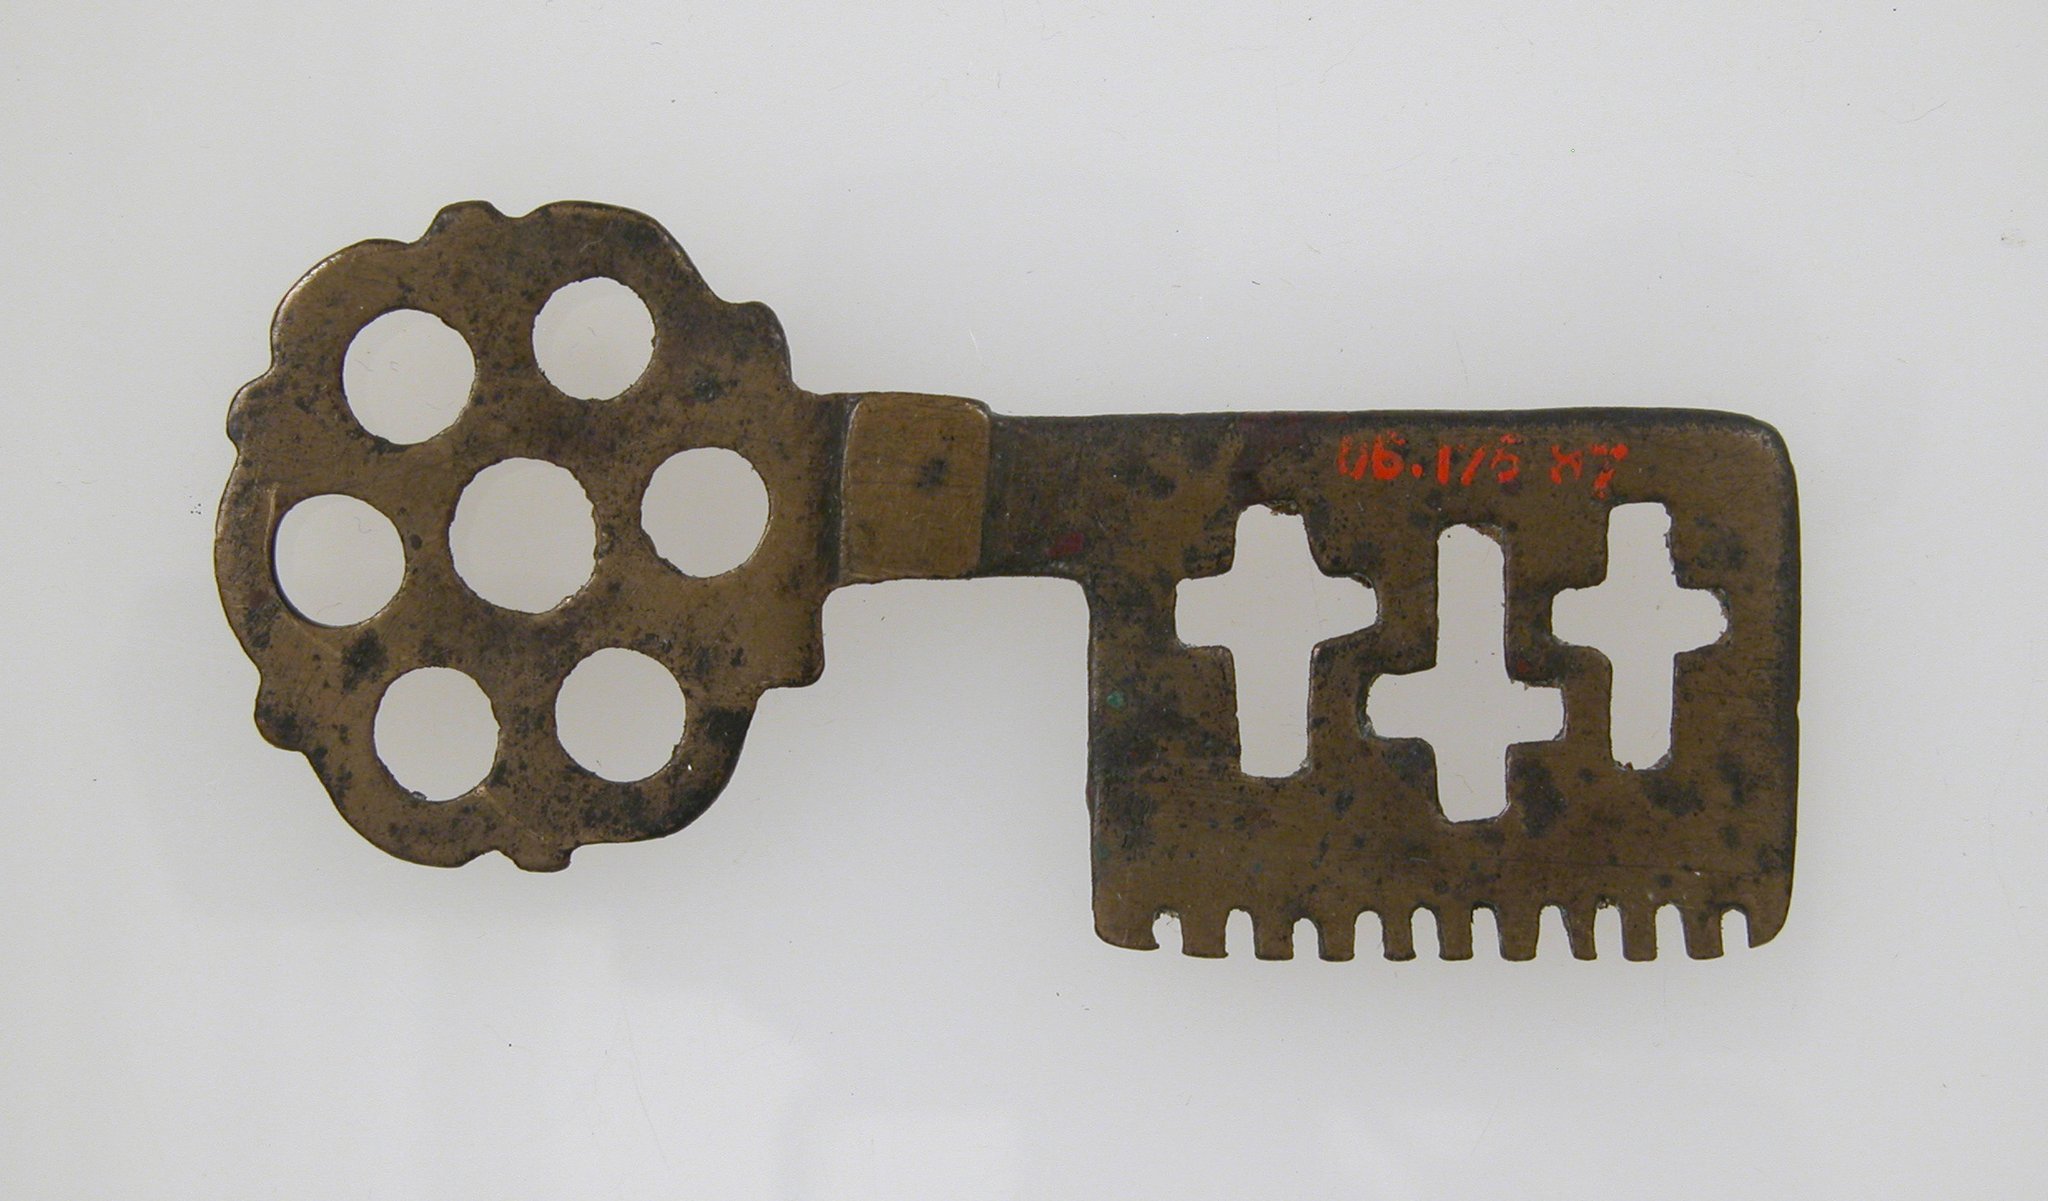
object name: key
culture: roman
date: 1-700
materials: copper alloy